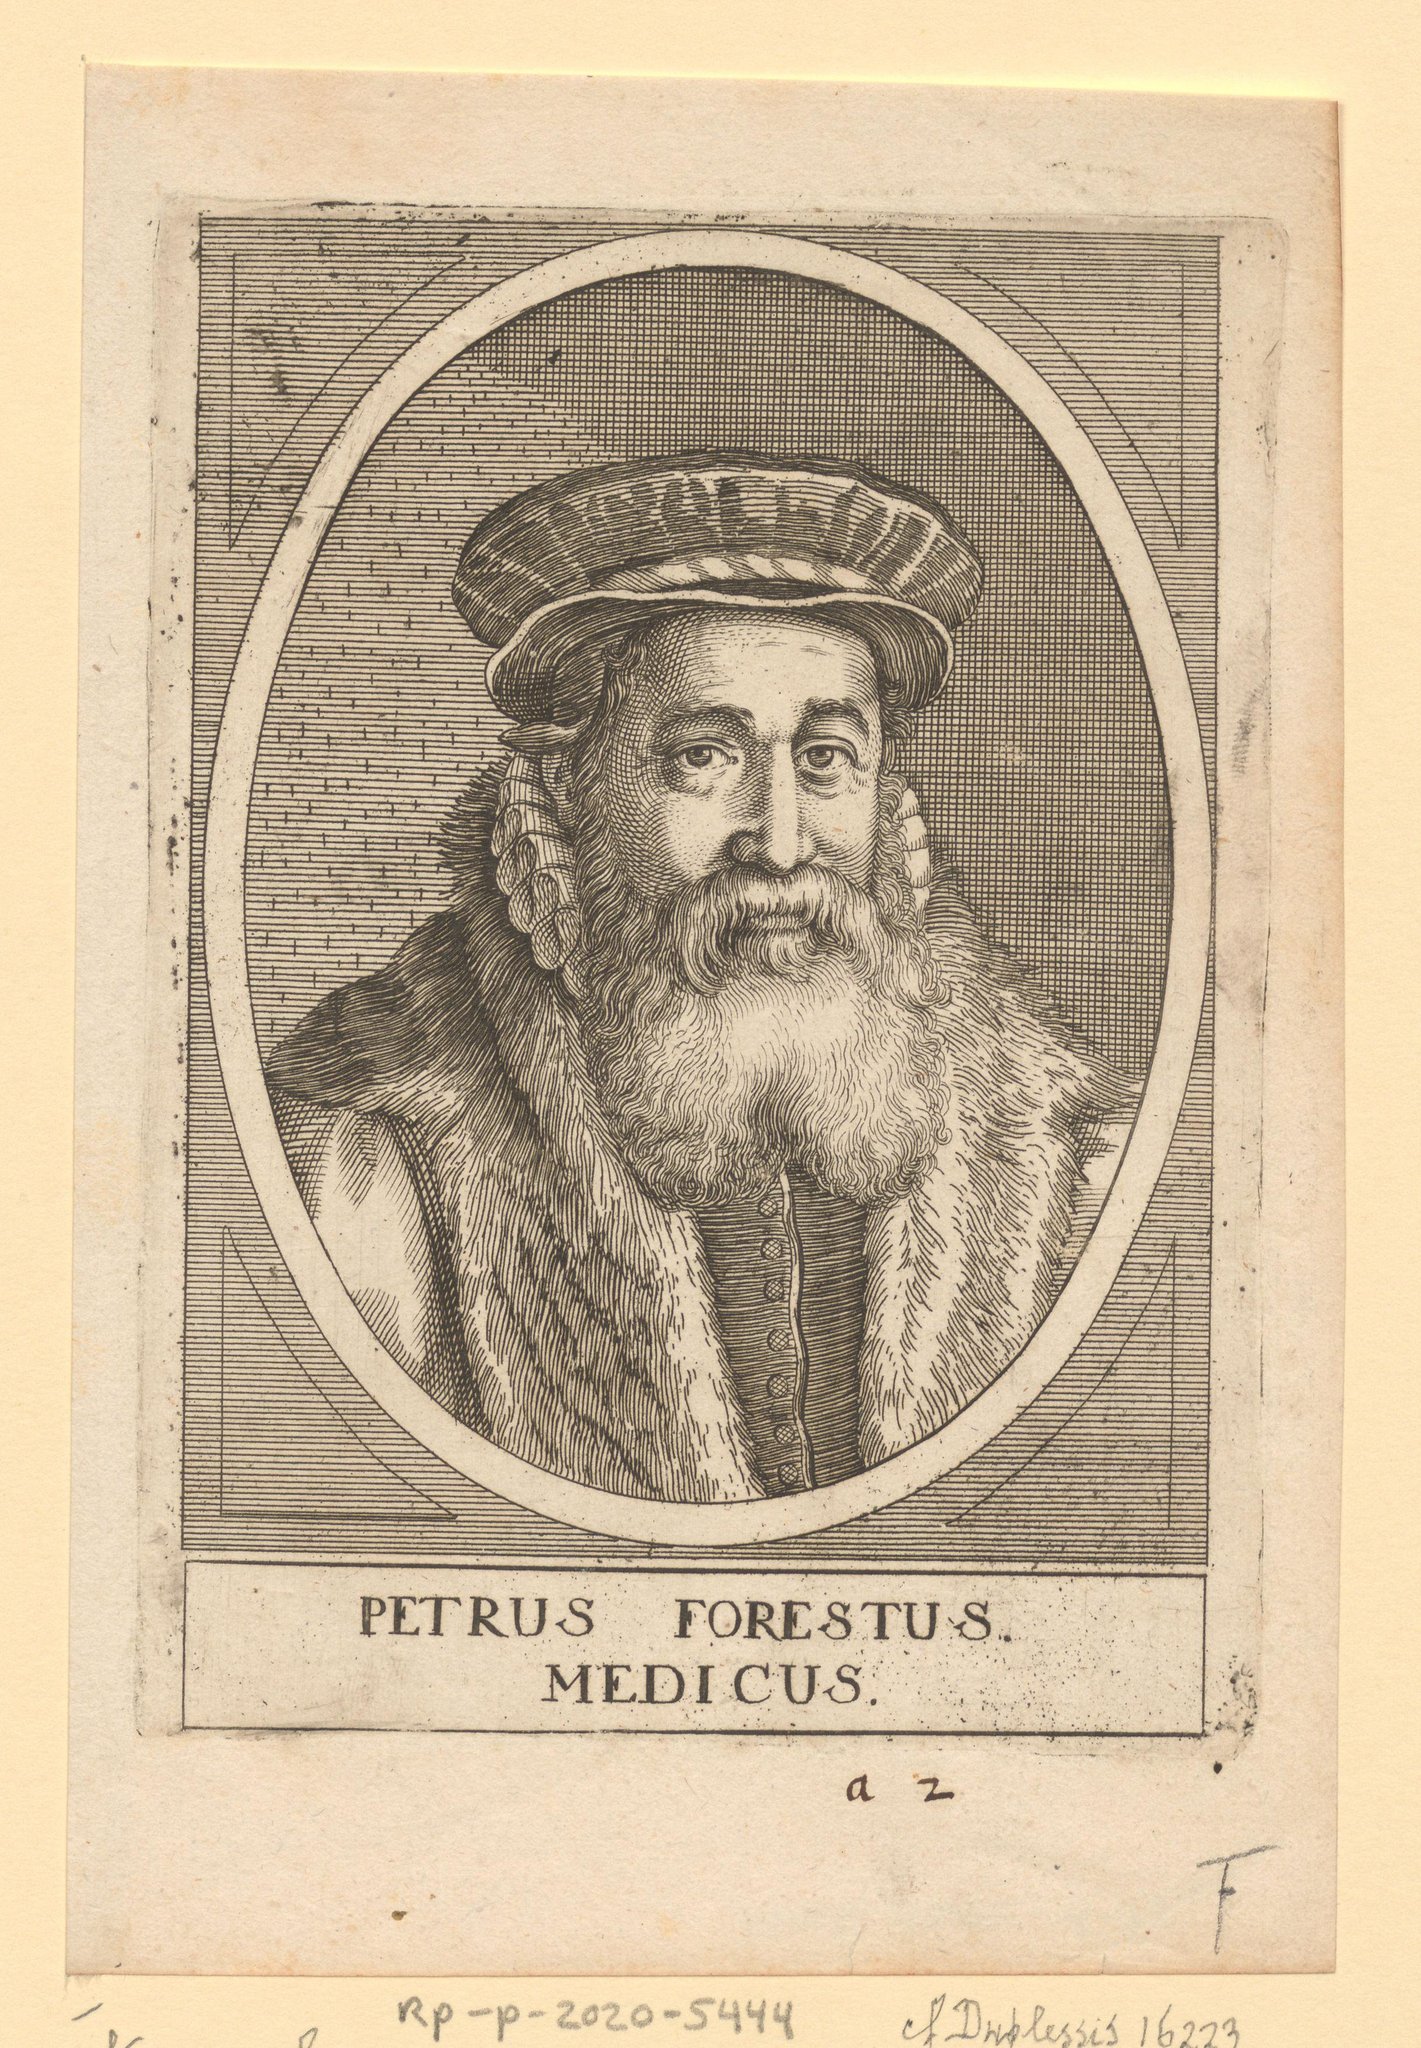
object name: print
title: Portret van Pieter van Foreest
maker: sebastian furck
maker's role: print maker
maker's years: 1600-1655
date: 1634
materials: paper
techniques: engraving, etching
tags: historical persons, physician, doctor (+ portrait of scholar, scientist)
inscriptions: inscription: ‘a 2’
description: Prent waarschijnlijk uit: Iconum viros virtute atque eruditione illustros repraesentantium (...). Frankfurt am Main: Johannes Ammon, 1634. Latere staat waarschijnlijk gebruikt voor: Bibliotheca chalcographica. Frankfurt am Main: Johannes Ammon, 1650-1652.